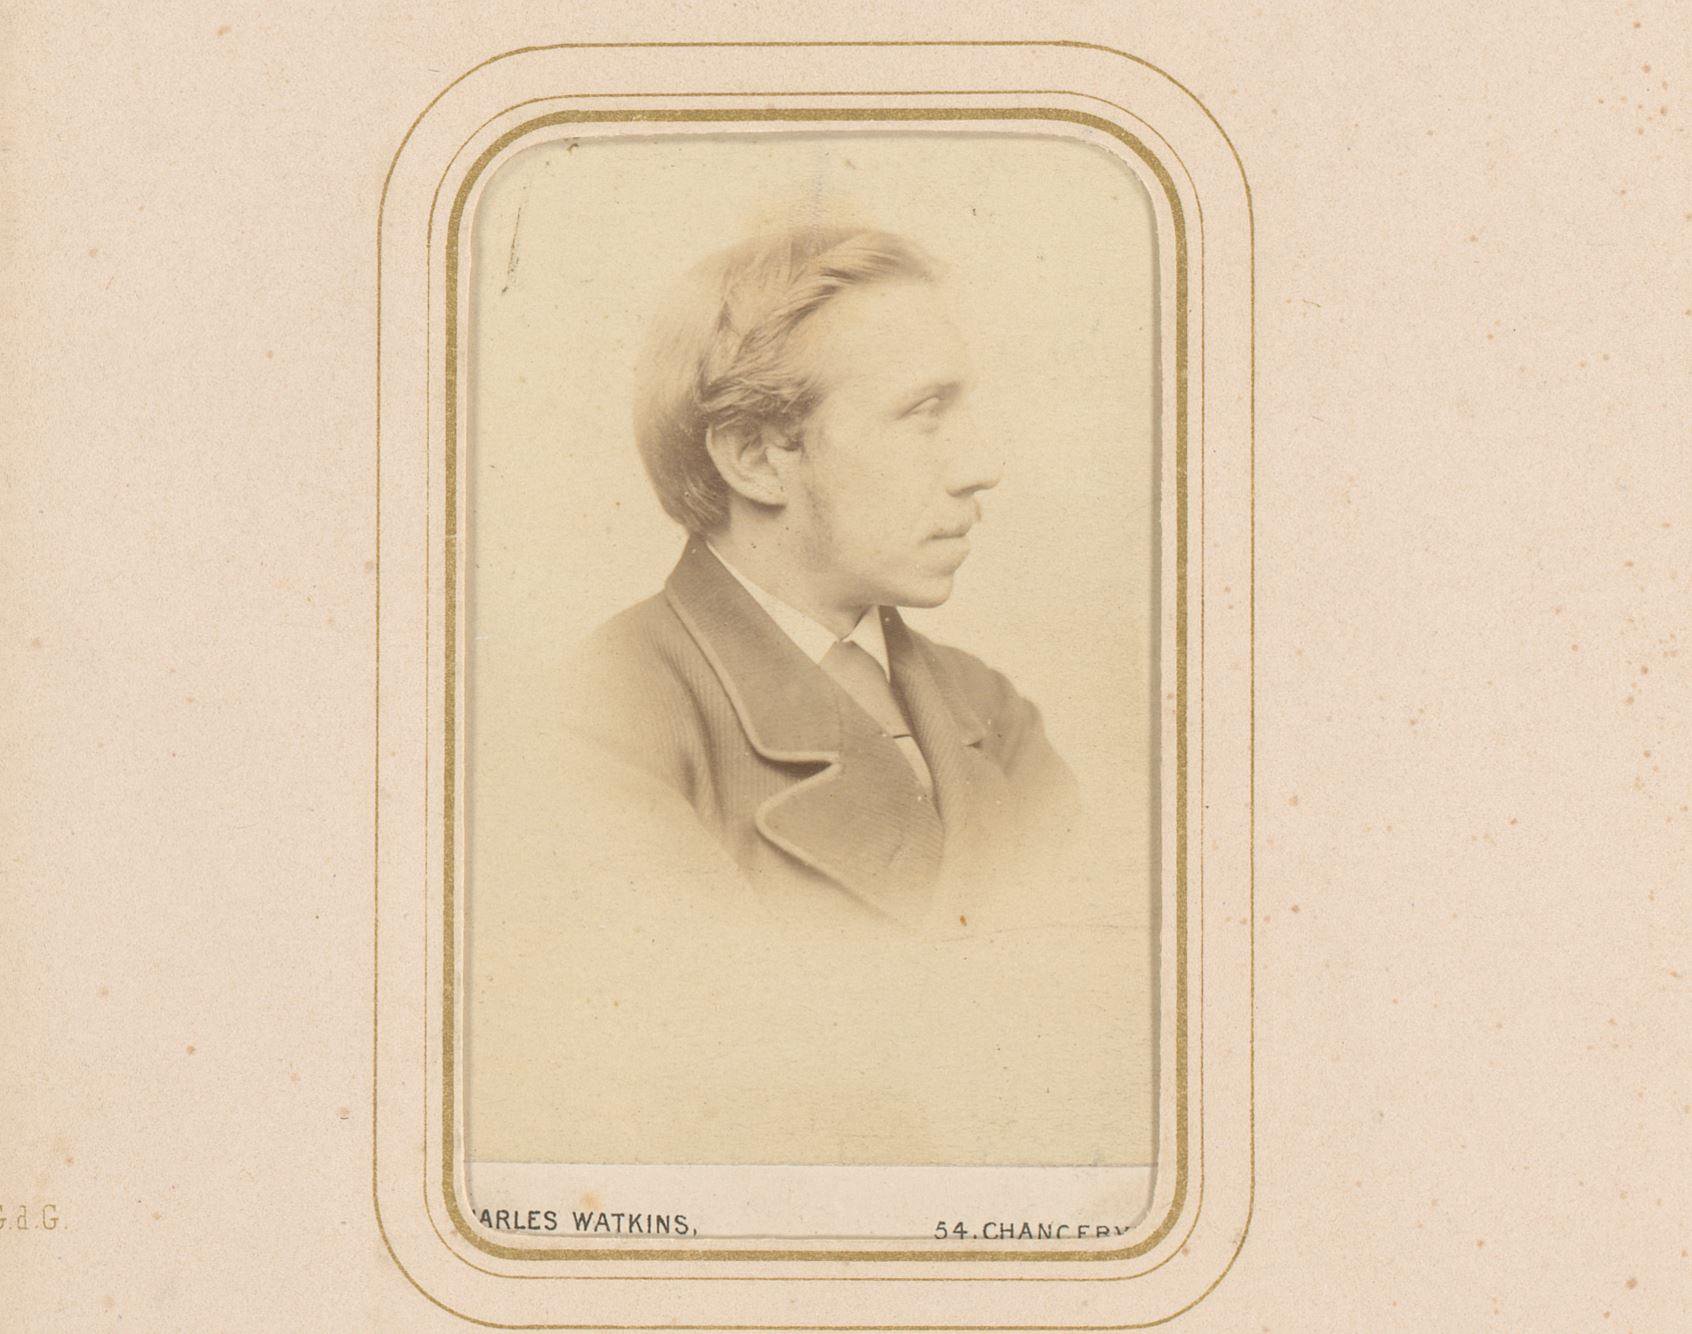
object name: carte de visite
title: Portret van een man, en profil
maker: charles watkins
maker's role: fotograaf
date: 1860-1900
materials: cardboard, photographic support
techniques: albumen print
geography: london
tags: historical persons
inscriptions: inscription: ‘Charles Watkins/ Photographer/ 54, Chancery Lane./ London/ w.c.’